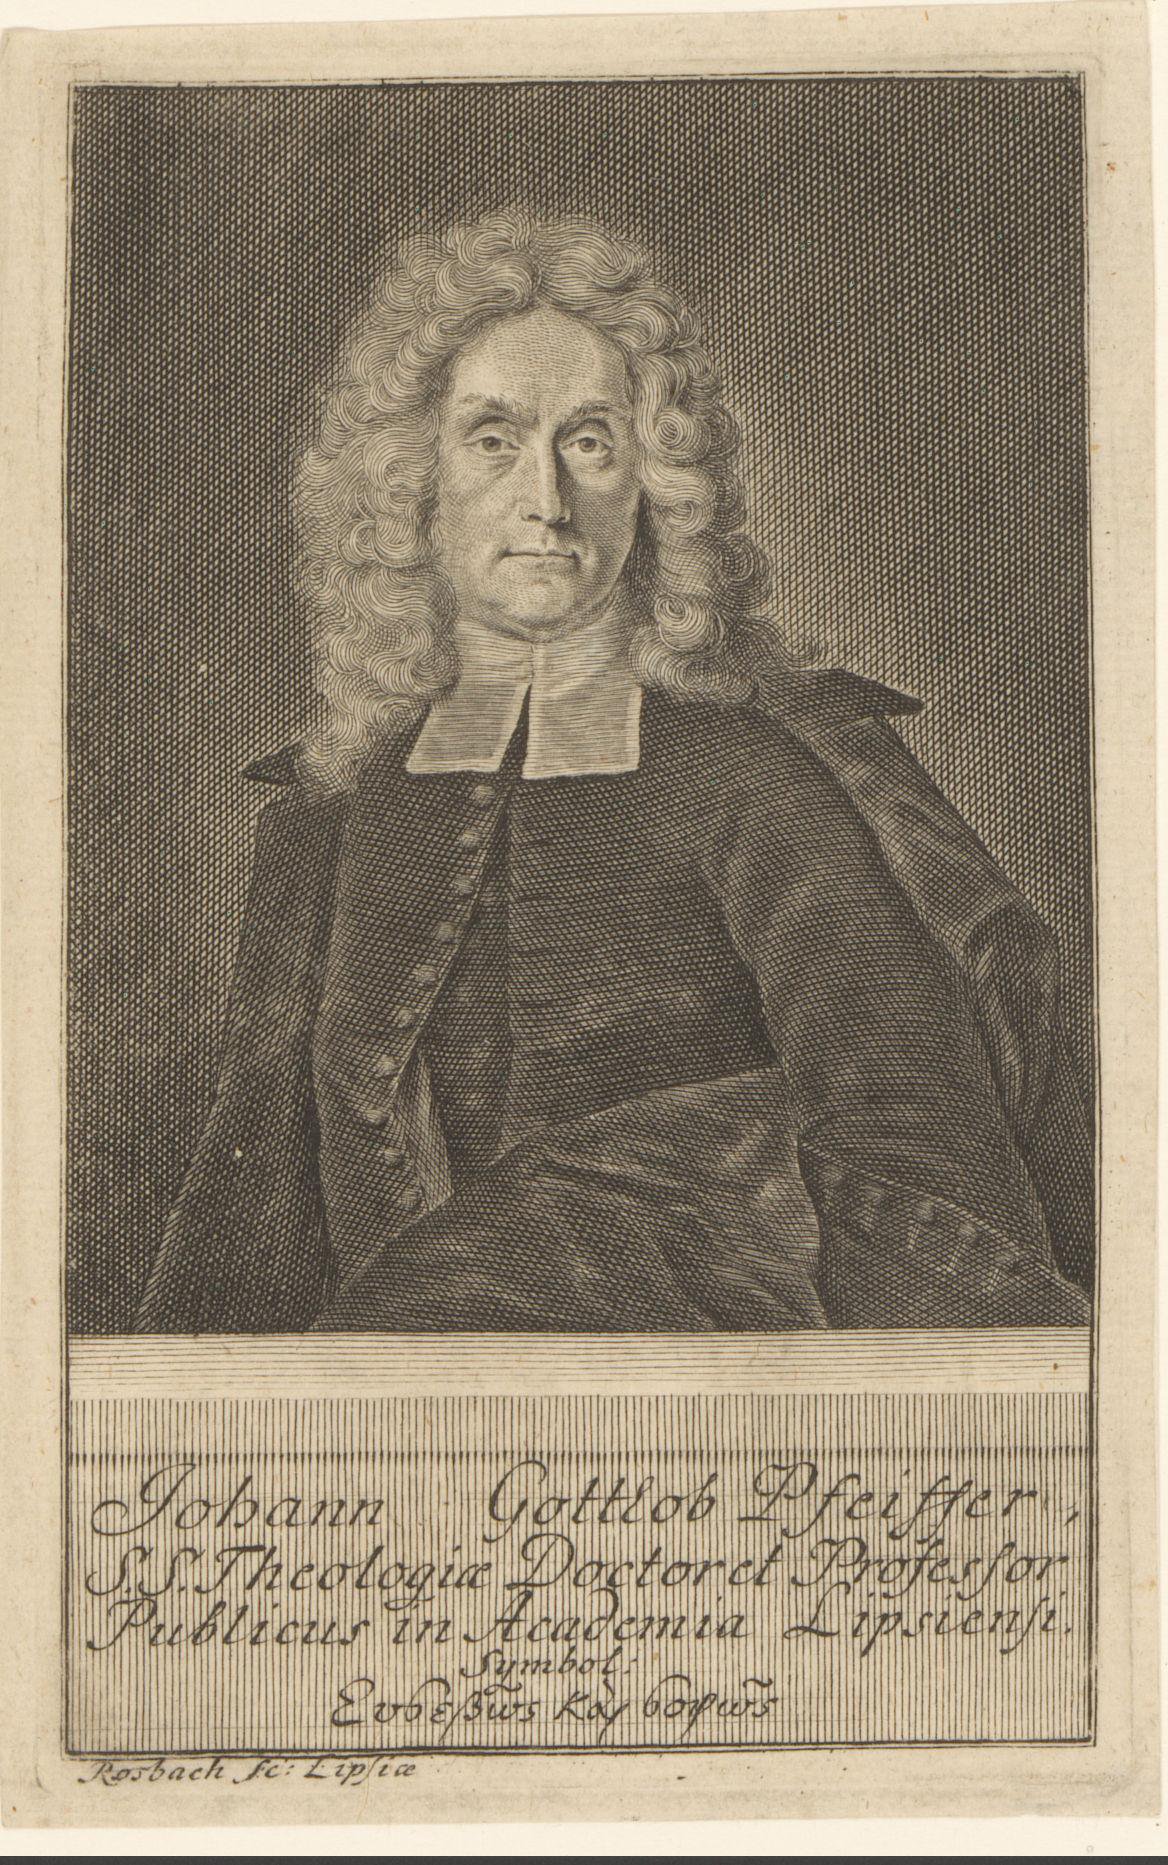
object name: print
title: Portret van Johann Gottlob Pfeiffer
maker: johann friedrich rosbach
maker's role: print maker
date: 1700-1749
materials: paper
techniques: engraving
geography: leipzig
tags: historical persons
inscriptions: collector's mark: Lugt 2228